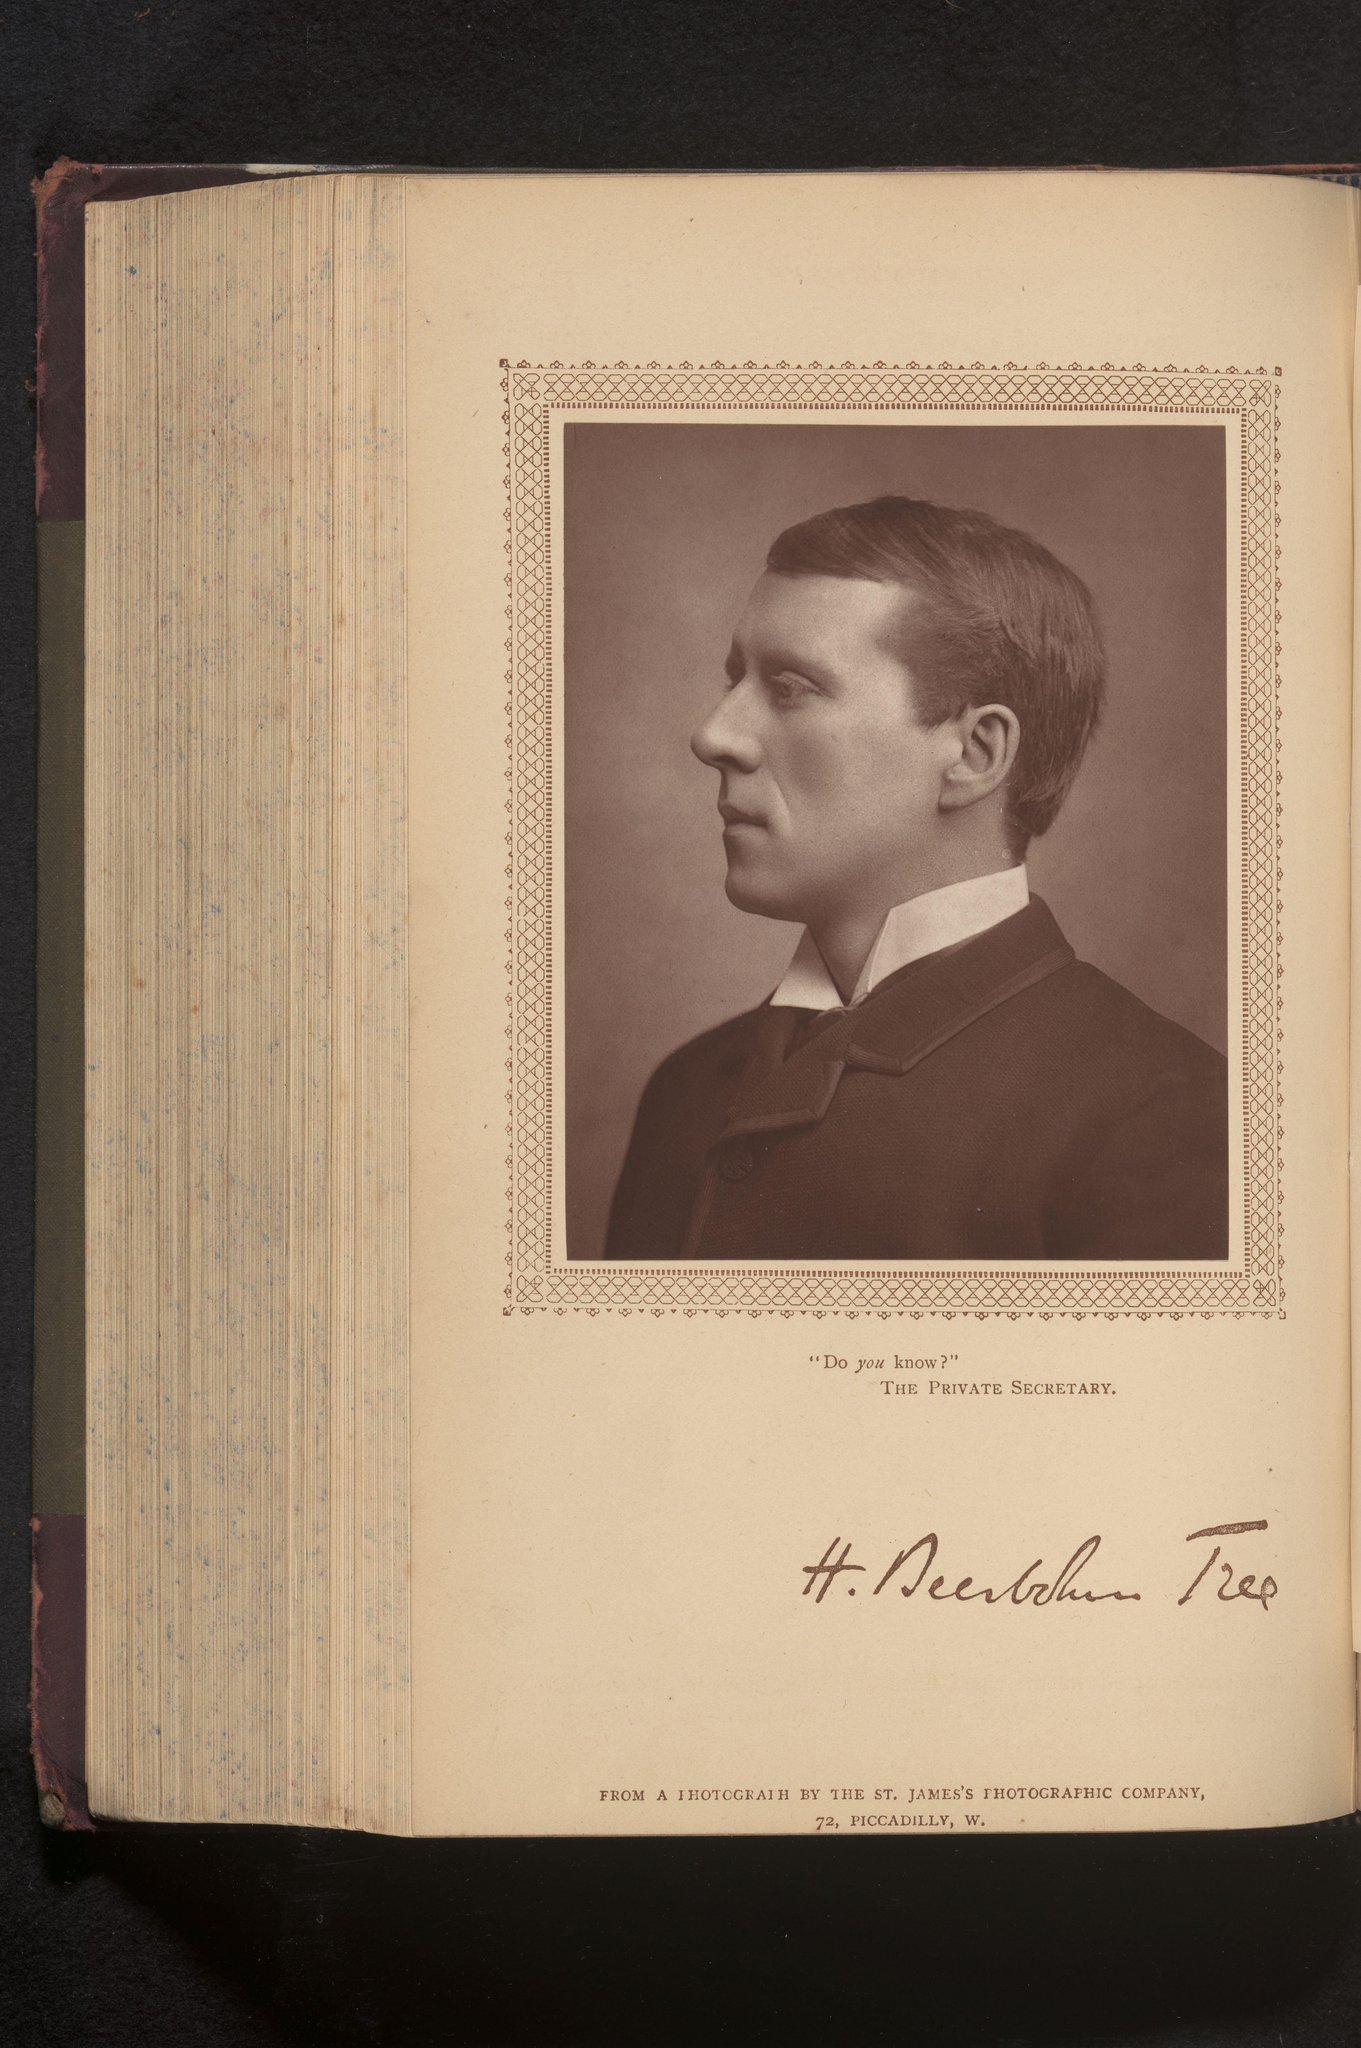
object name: page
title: Portret van Herbert Beerbohm-Tree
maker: Anonymous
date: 1879-1884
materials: paper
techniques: woodburytype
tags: adult man, historical persons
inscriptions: signature: ‘H Beerbohm Tree’, inscription: ‘'Do you know?'/ Private secretary’